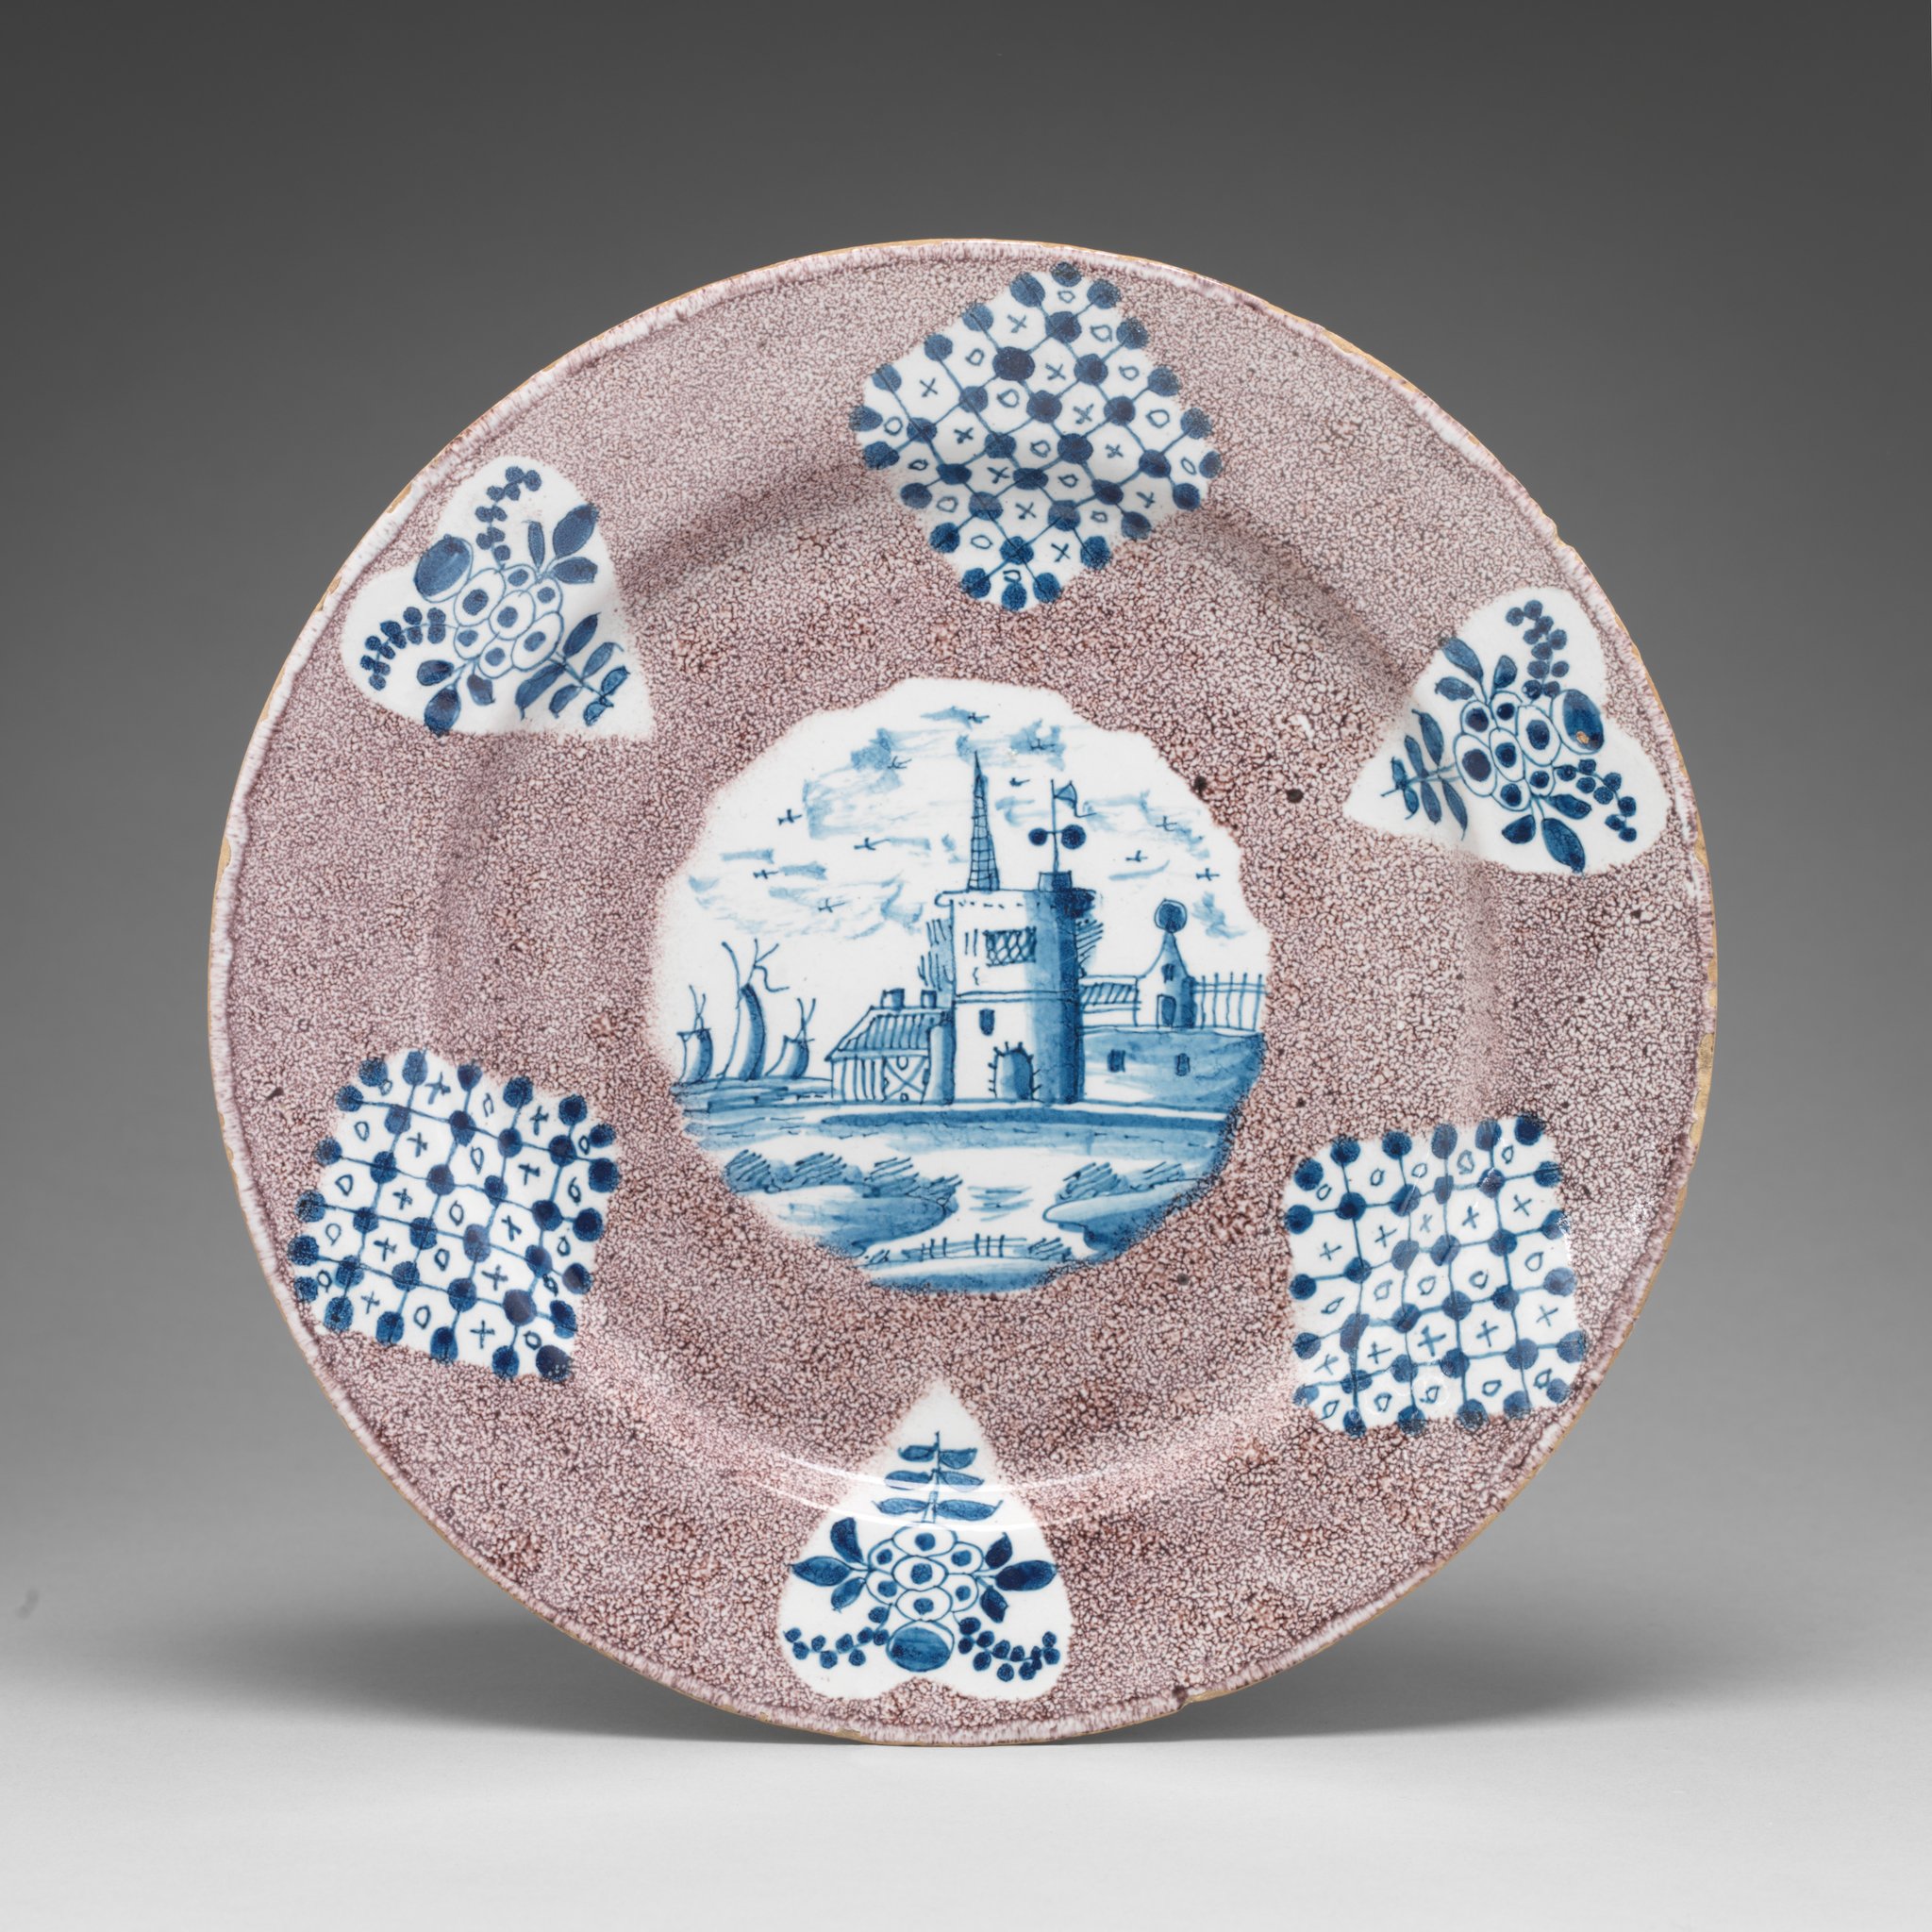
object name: plate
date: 1750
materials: earthenware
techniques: glazing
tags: castles